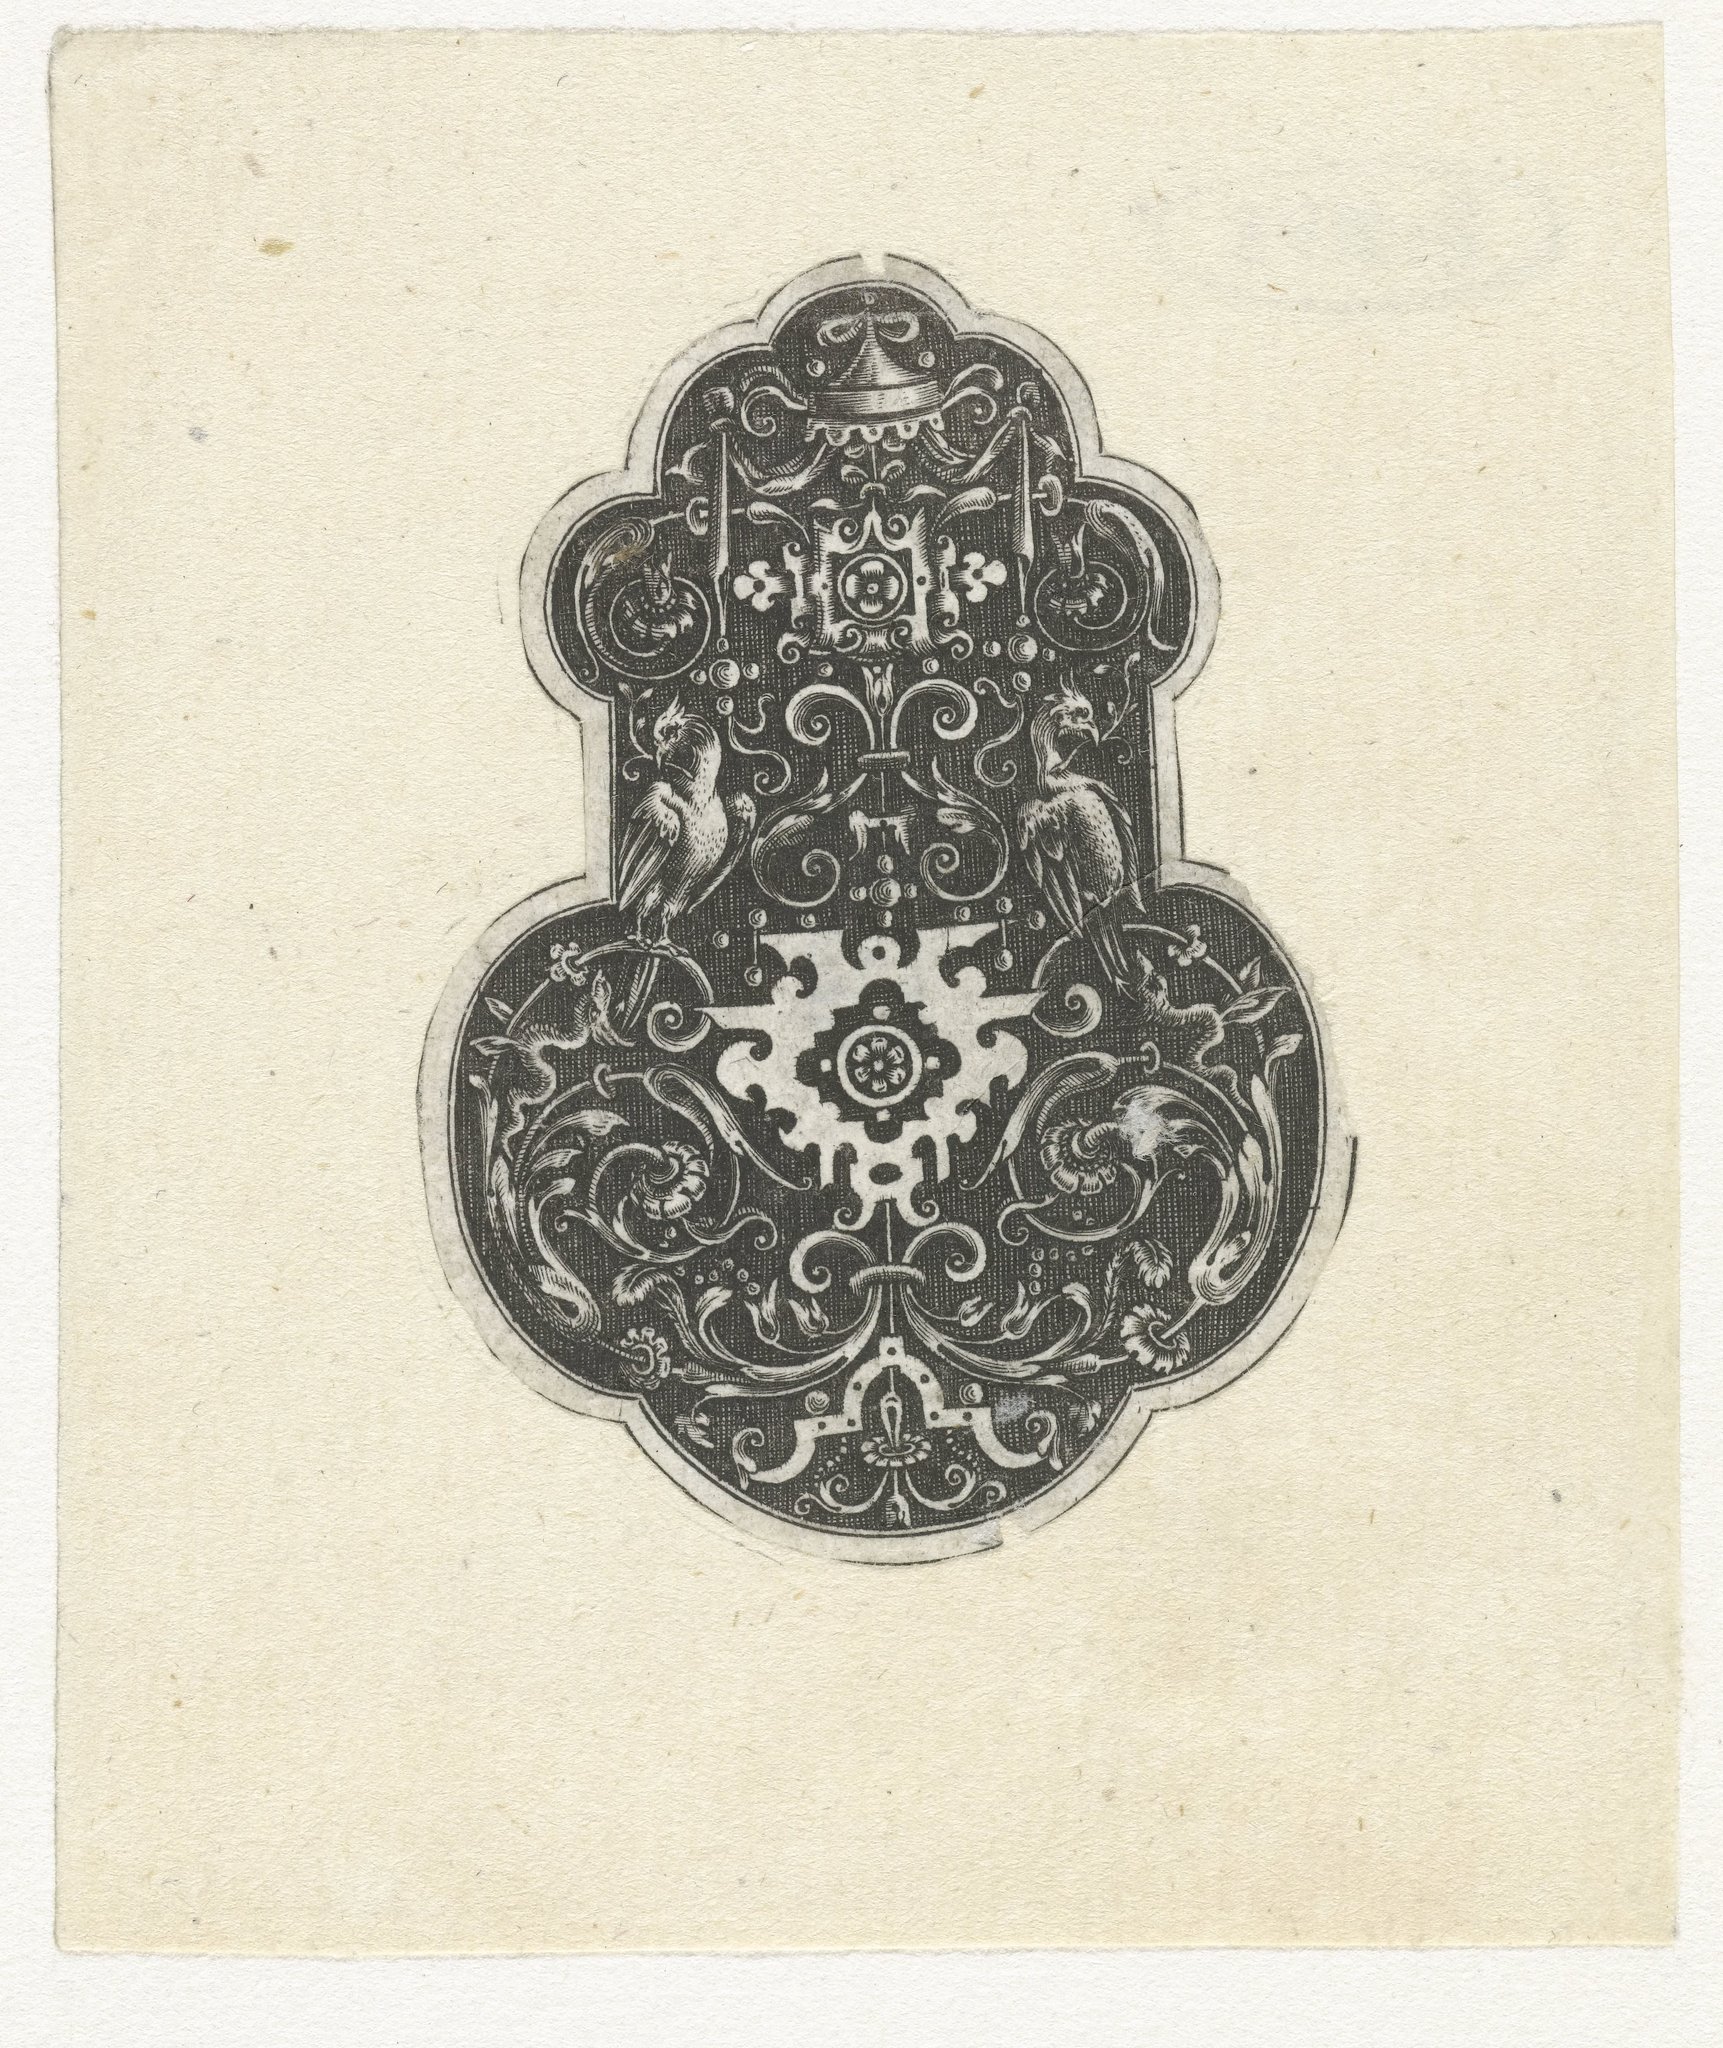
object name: print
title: Stephanus De Lavne inventor excidebat anno d.1573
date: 1528-1573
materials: paper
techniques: engraving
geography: france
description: Uit serie, bestaande uit een titelblad en 6 bladen met ornamenten in de vorm van een hanger met een decoratie van grotesken en bladranken.